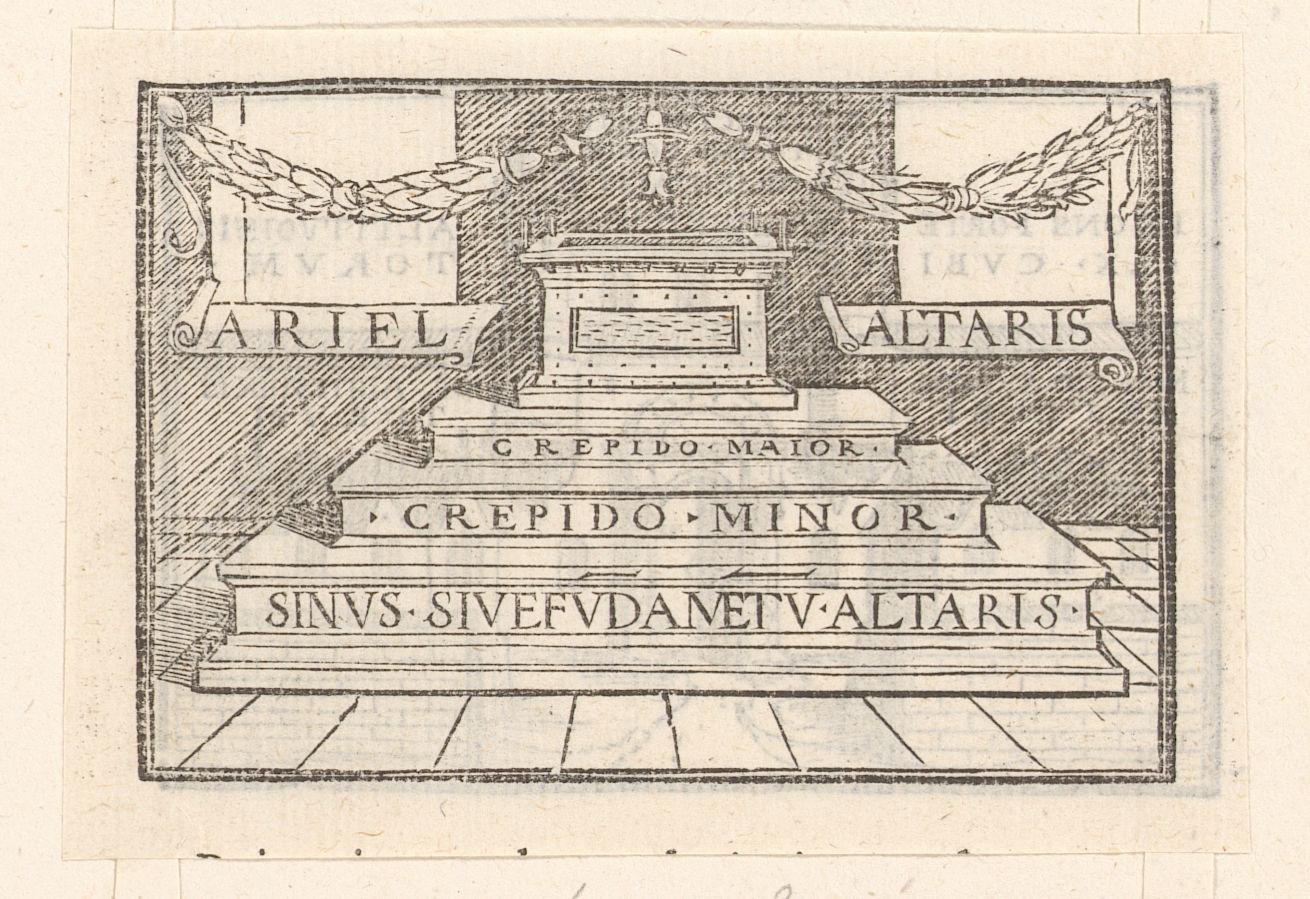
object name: book illustration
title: Altaar in de nieuwe tempel in visioen van Ezechiël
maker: veit rudolf specklin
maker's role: print maker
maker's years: -1550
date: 1538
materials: paper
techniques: woodcut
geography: switzerland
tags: the lord's ordinances of the altar ~ ezekiel's vision of the new temple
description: Boekillustratie voor het eerst gebruikt in: Biblia Utriusque Testamenti iuxta Vulgatam Translationem, Lyon, M. en G. Trechsel (voor Hugo à Porta) 1538. Later in verschillende uitgaven opnieuw gebruikt. Deze prent vermoedelijk gebruikt in één van de uitgaven uitgegeven en/of gedrukt door Jean Frellon, Lyon.